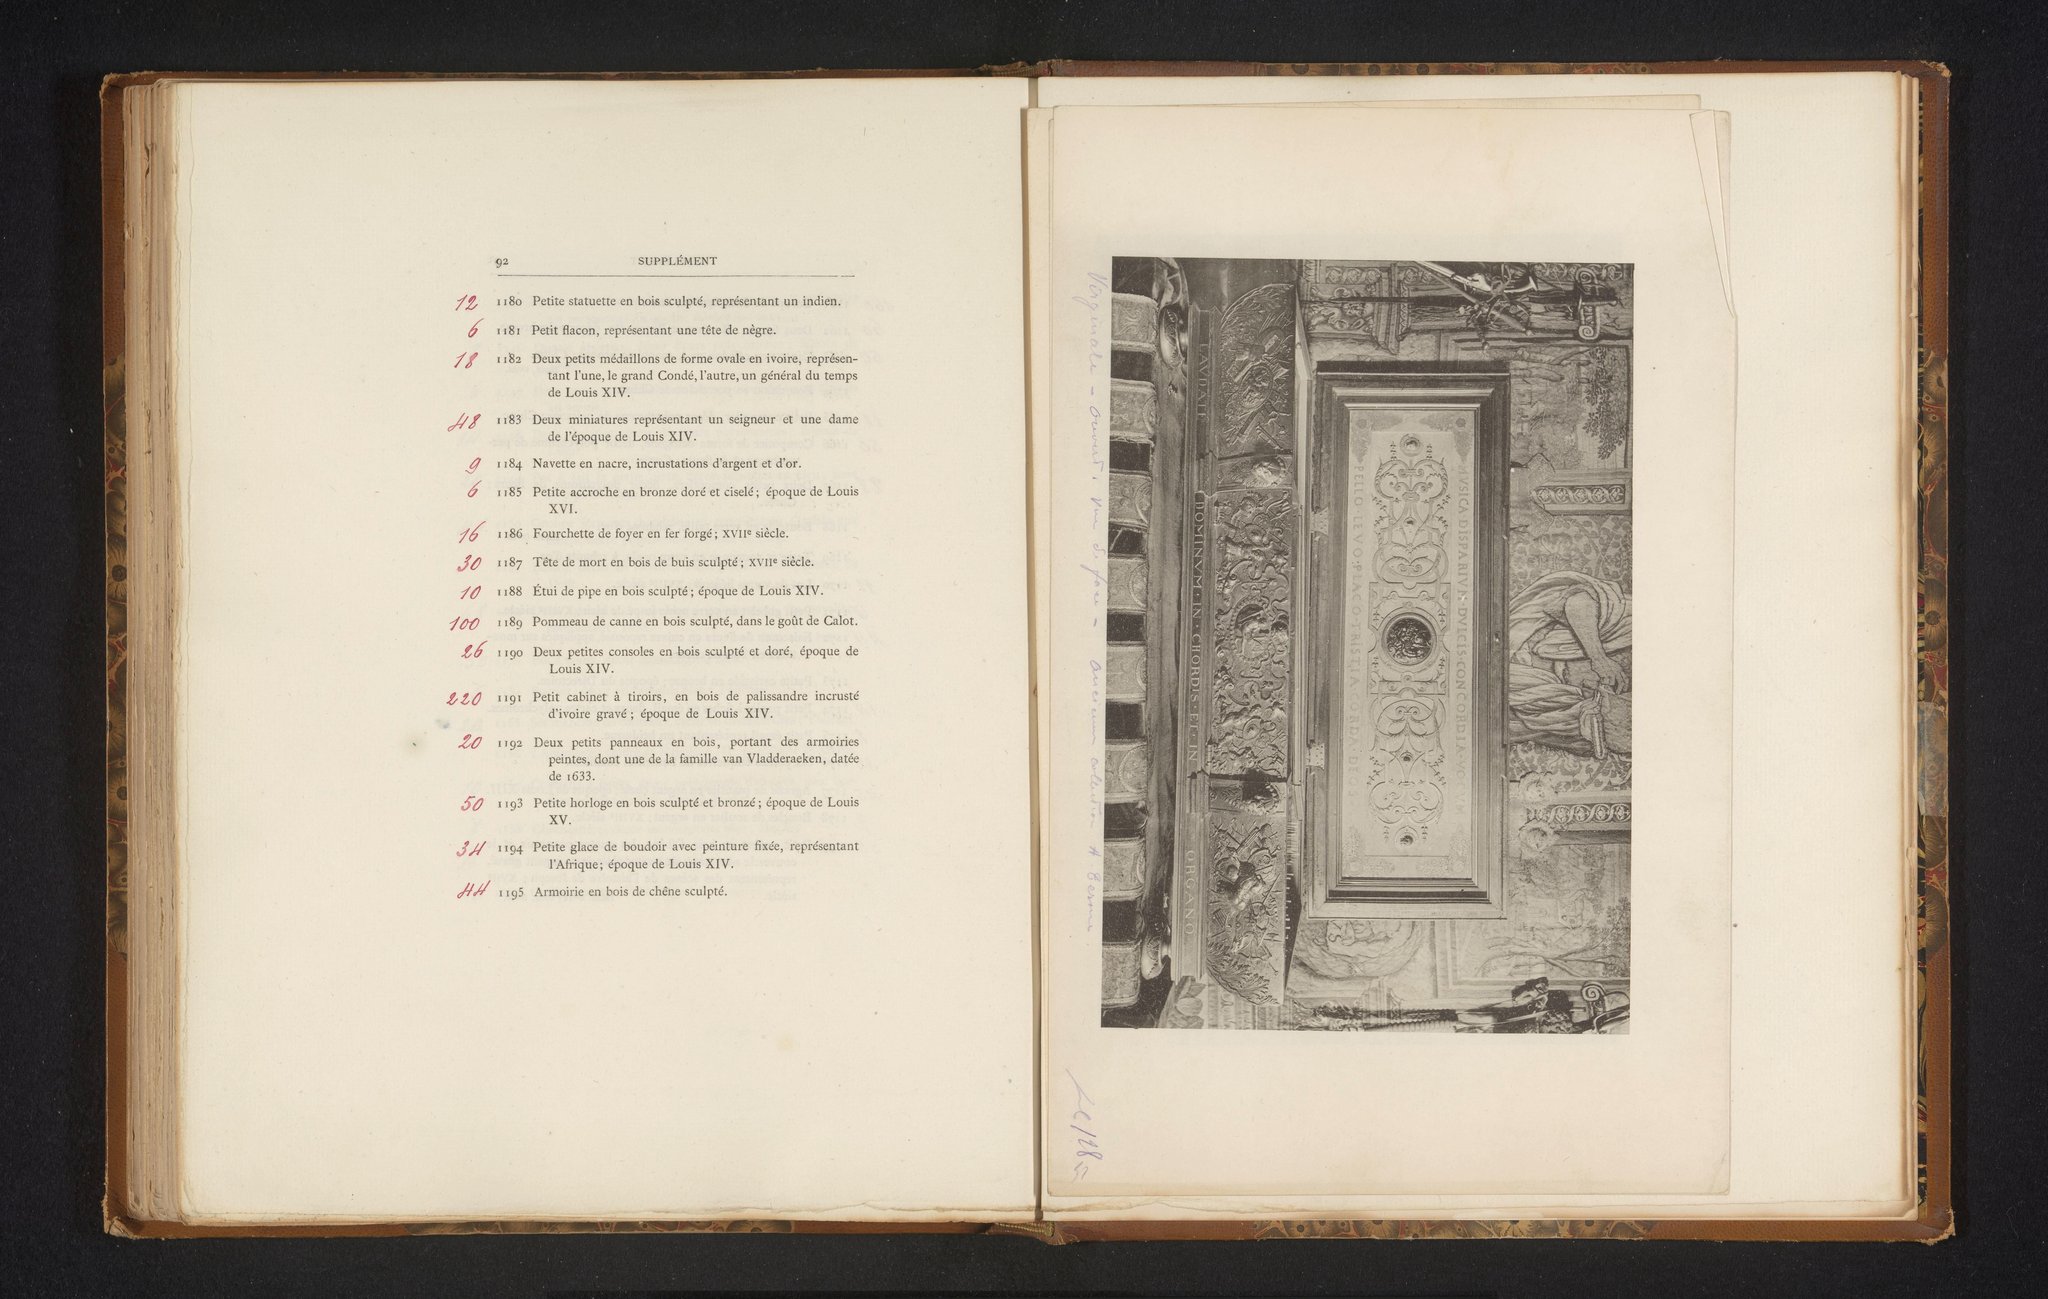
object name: page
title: Virginaal Hertog van Kleef uit de collectie van Antonin Terme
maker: Anonymous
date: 1880-1885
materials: paper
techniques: photograph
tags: art collection, art gallery, spinet, virginal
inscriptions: annotation: ‘Virginale - ouvert vue [...] collection A. Terme/ 128 =’